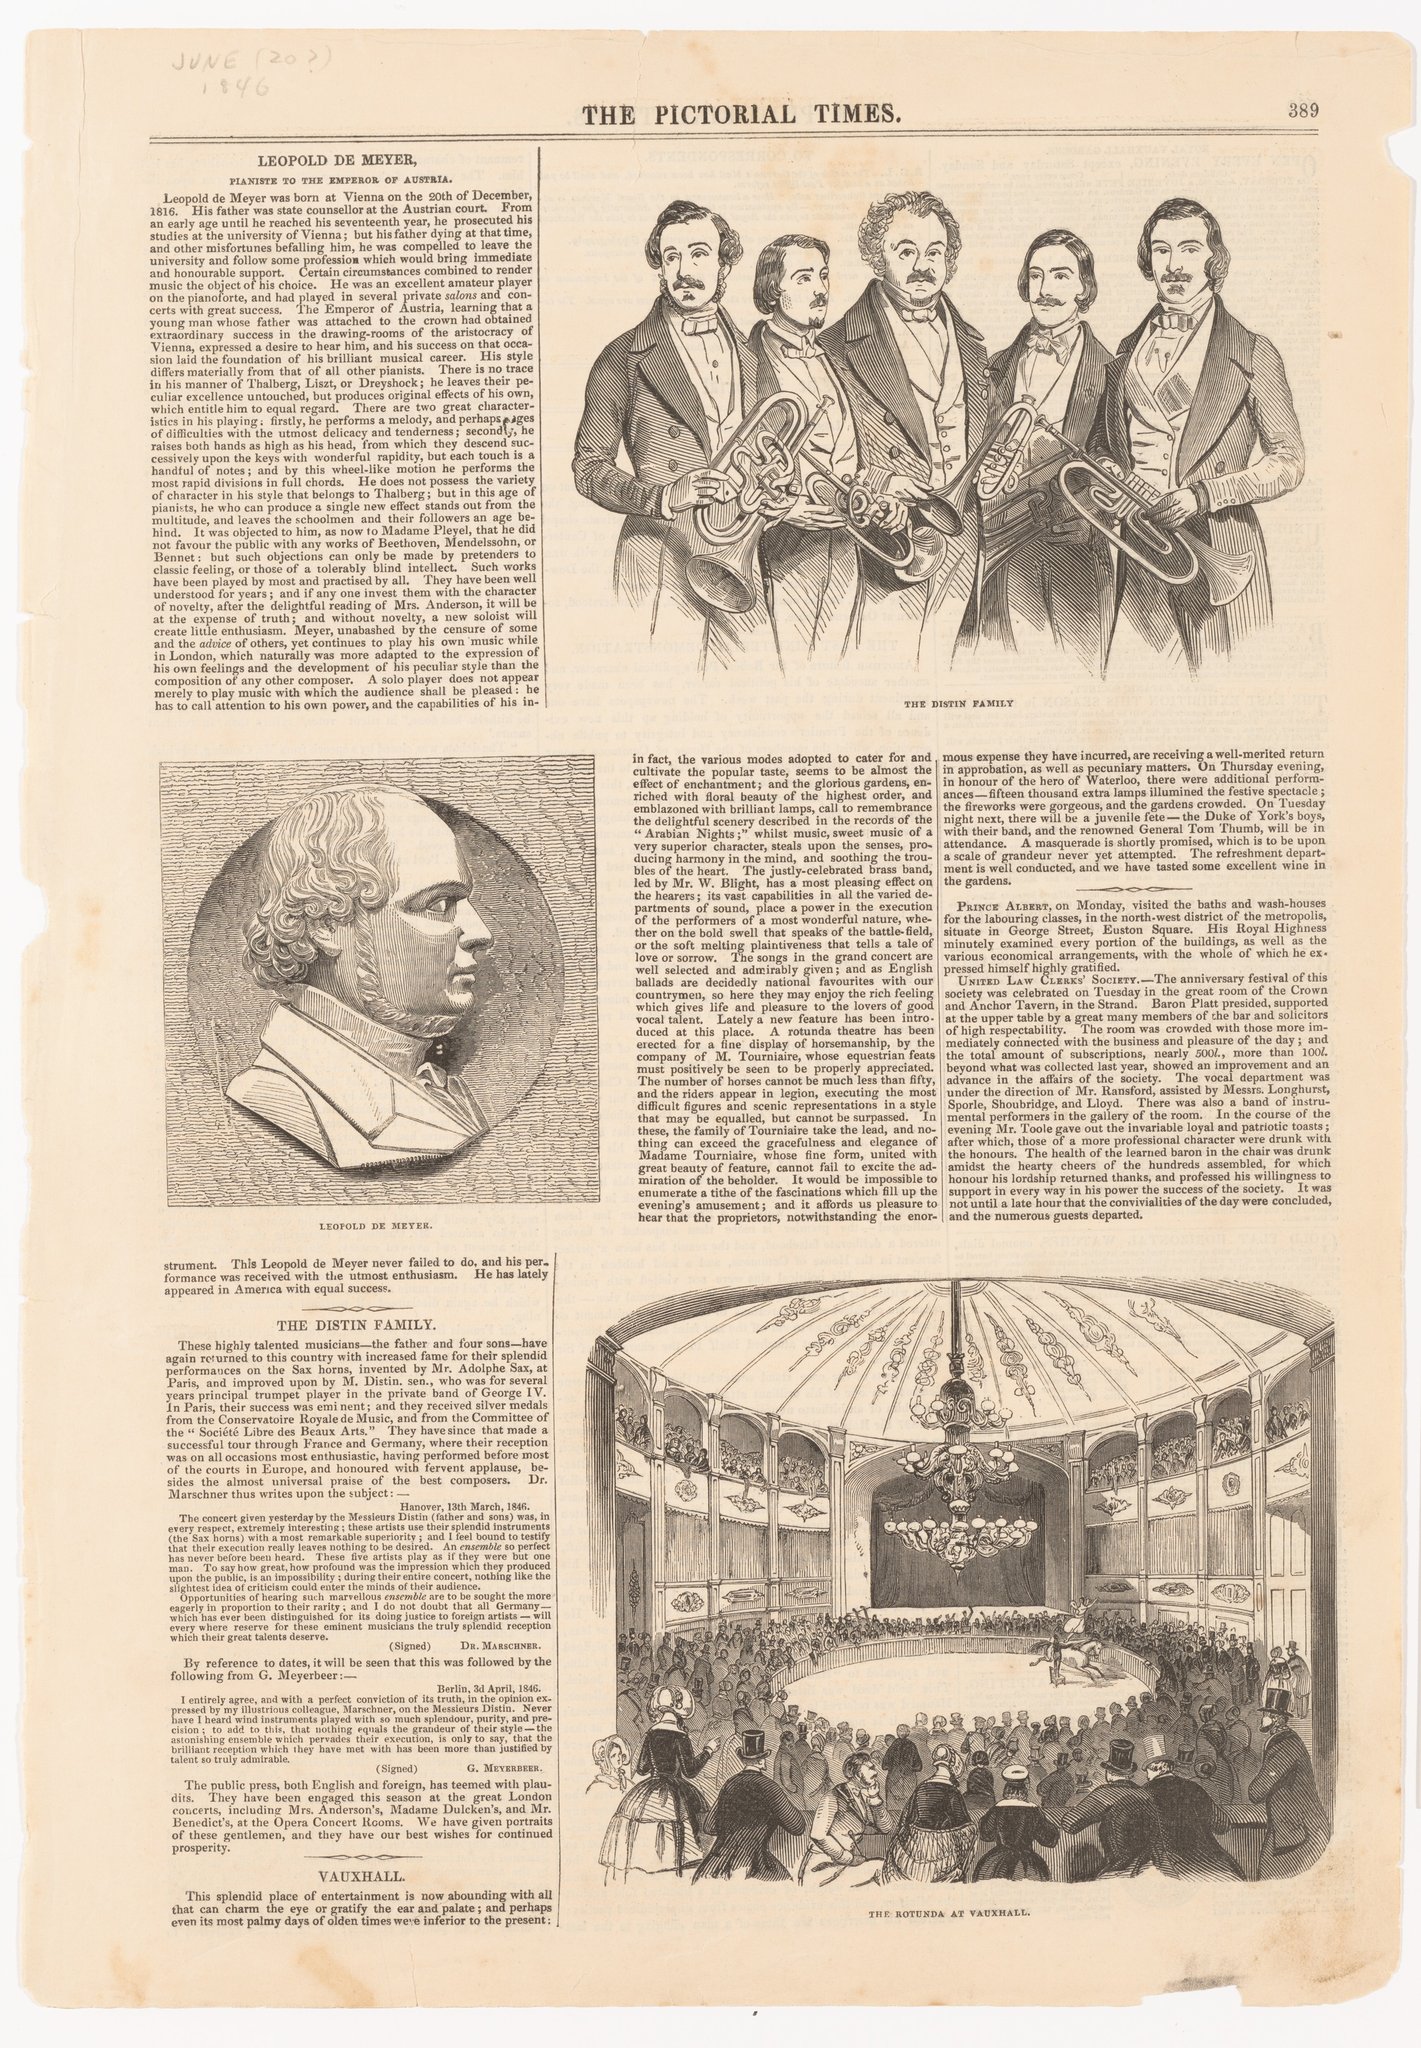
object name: newspaper illustration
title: The Distin Family newspaper illustration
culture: american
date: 1846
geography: united states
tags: men,musicians,newspapers